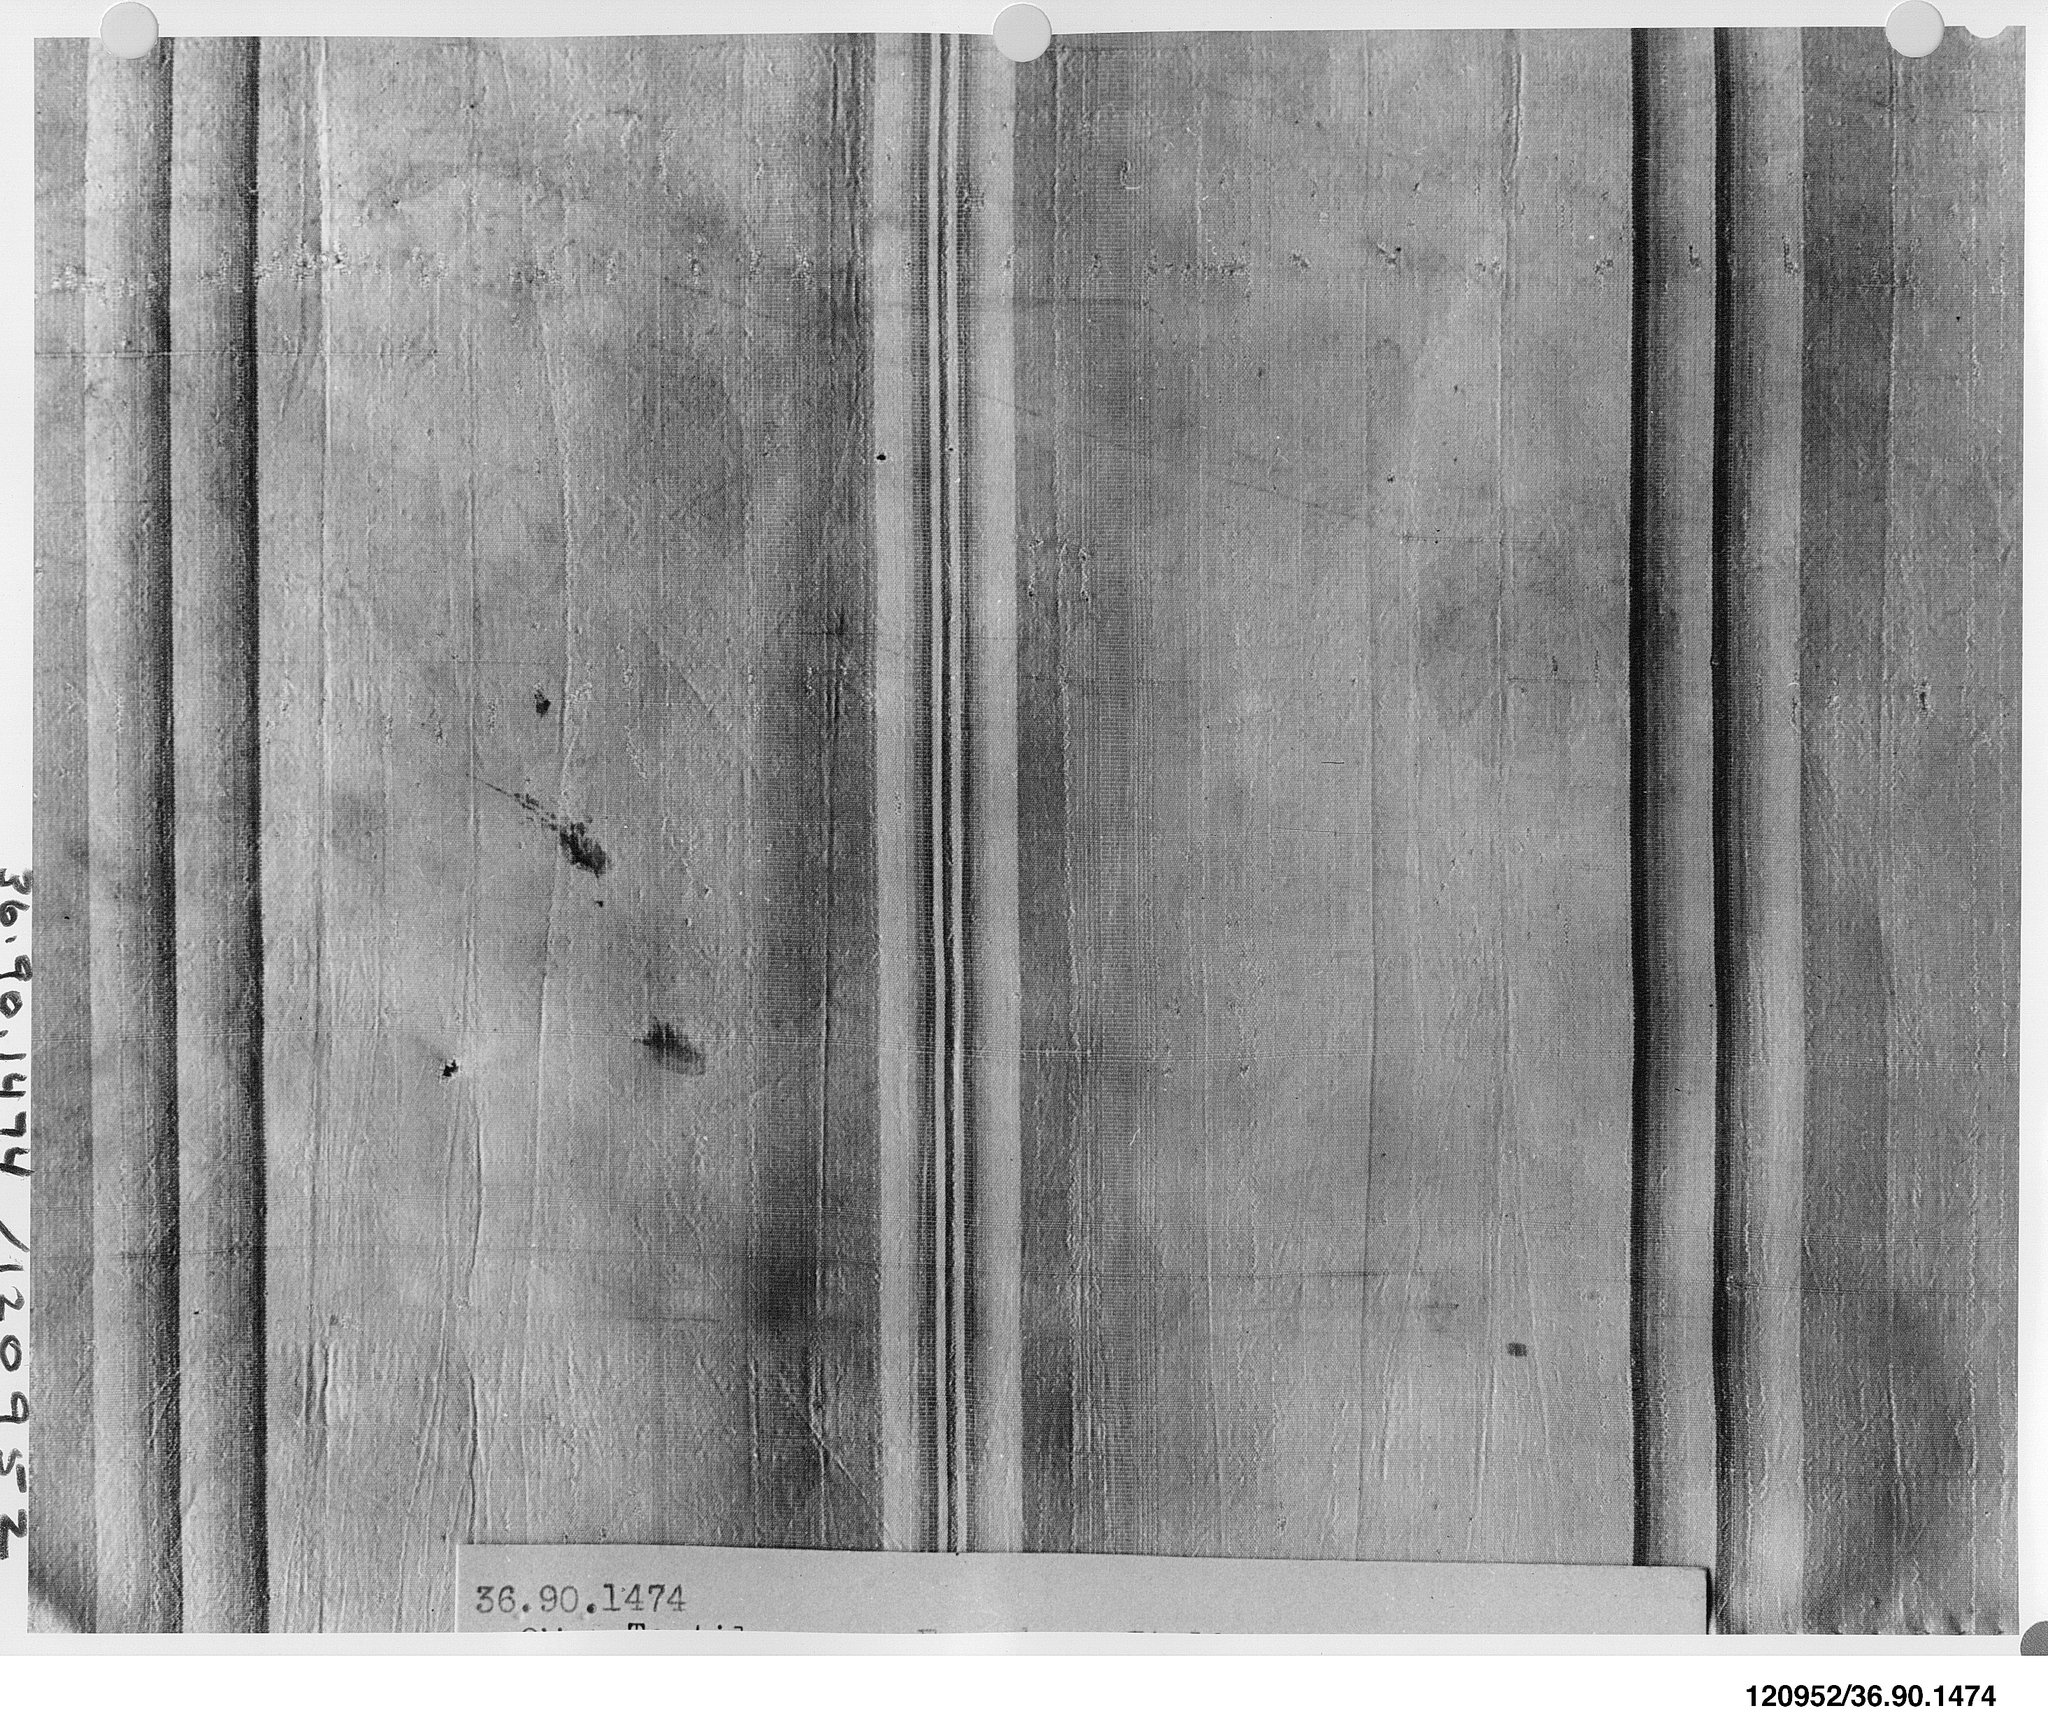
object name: piece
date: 1701-1800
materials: silk